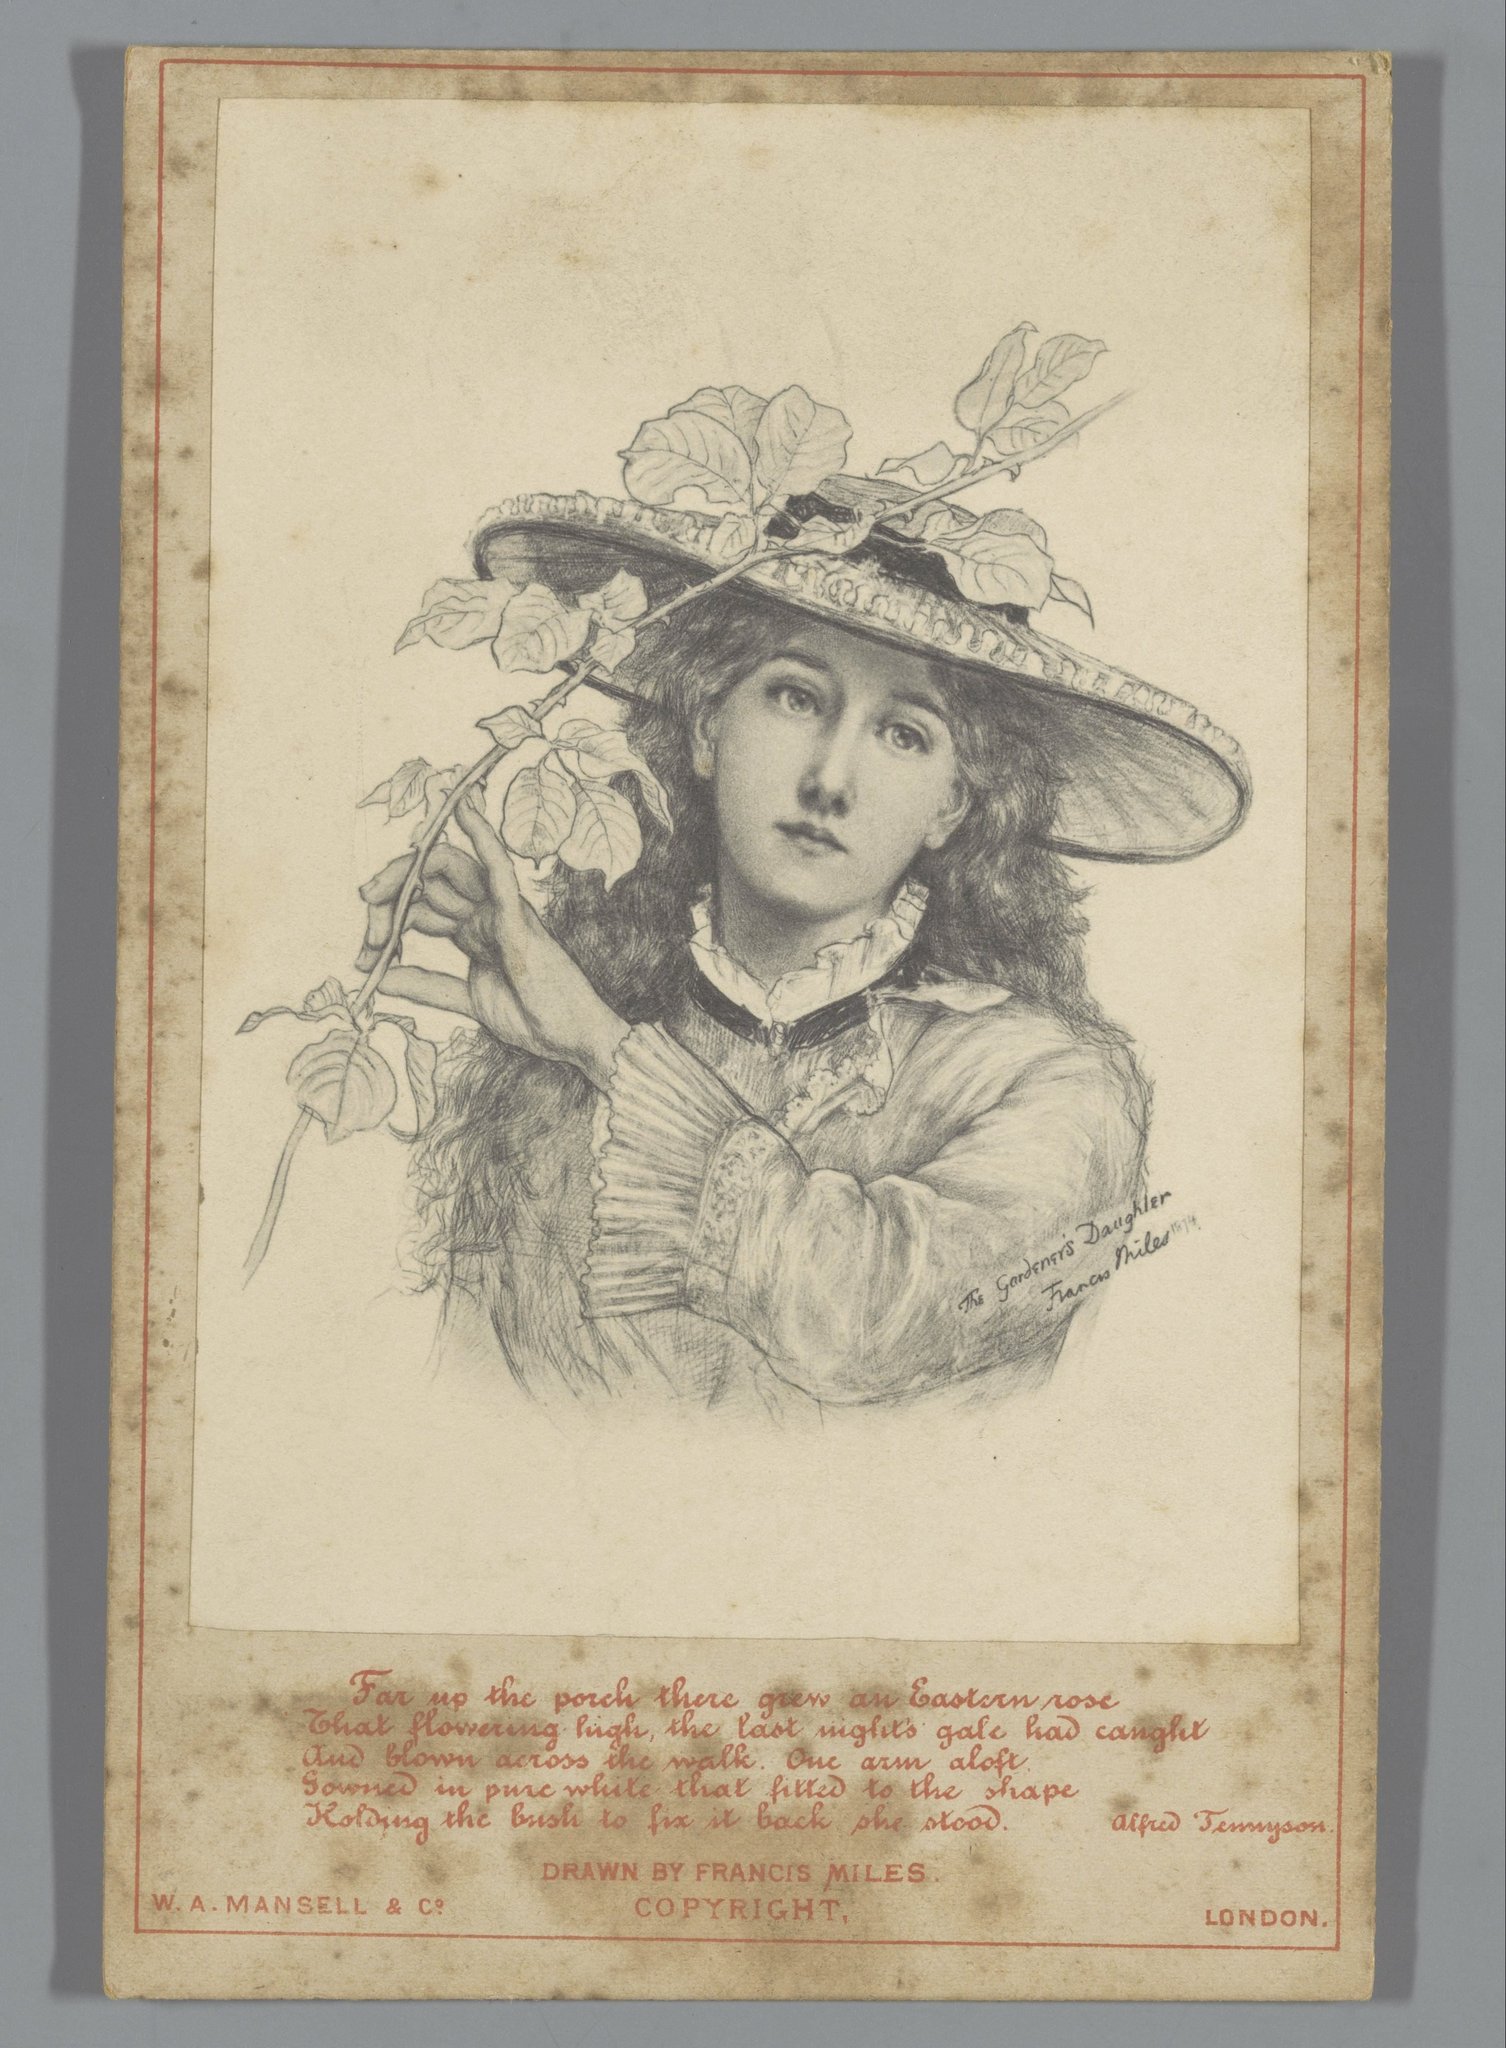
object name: cabinet photograph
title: The Gardener's Daughter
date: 1874-1890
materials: cardboard, paper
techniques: albumen print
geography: london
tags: adolescent, young woman, maiden, foliage, tendrils, branches ~ ornament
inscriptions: inscription: ‘Far up the (...) back she stood. Alfred Tennyson’, collector's mark: ‘Vosmaer’, inscription: ‘Ontvangst uit net eene/ kleine keyk mijner fijne/ pakkie voor uw persoon./ N’